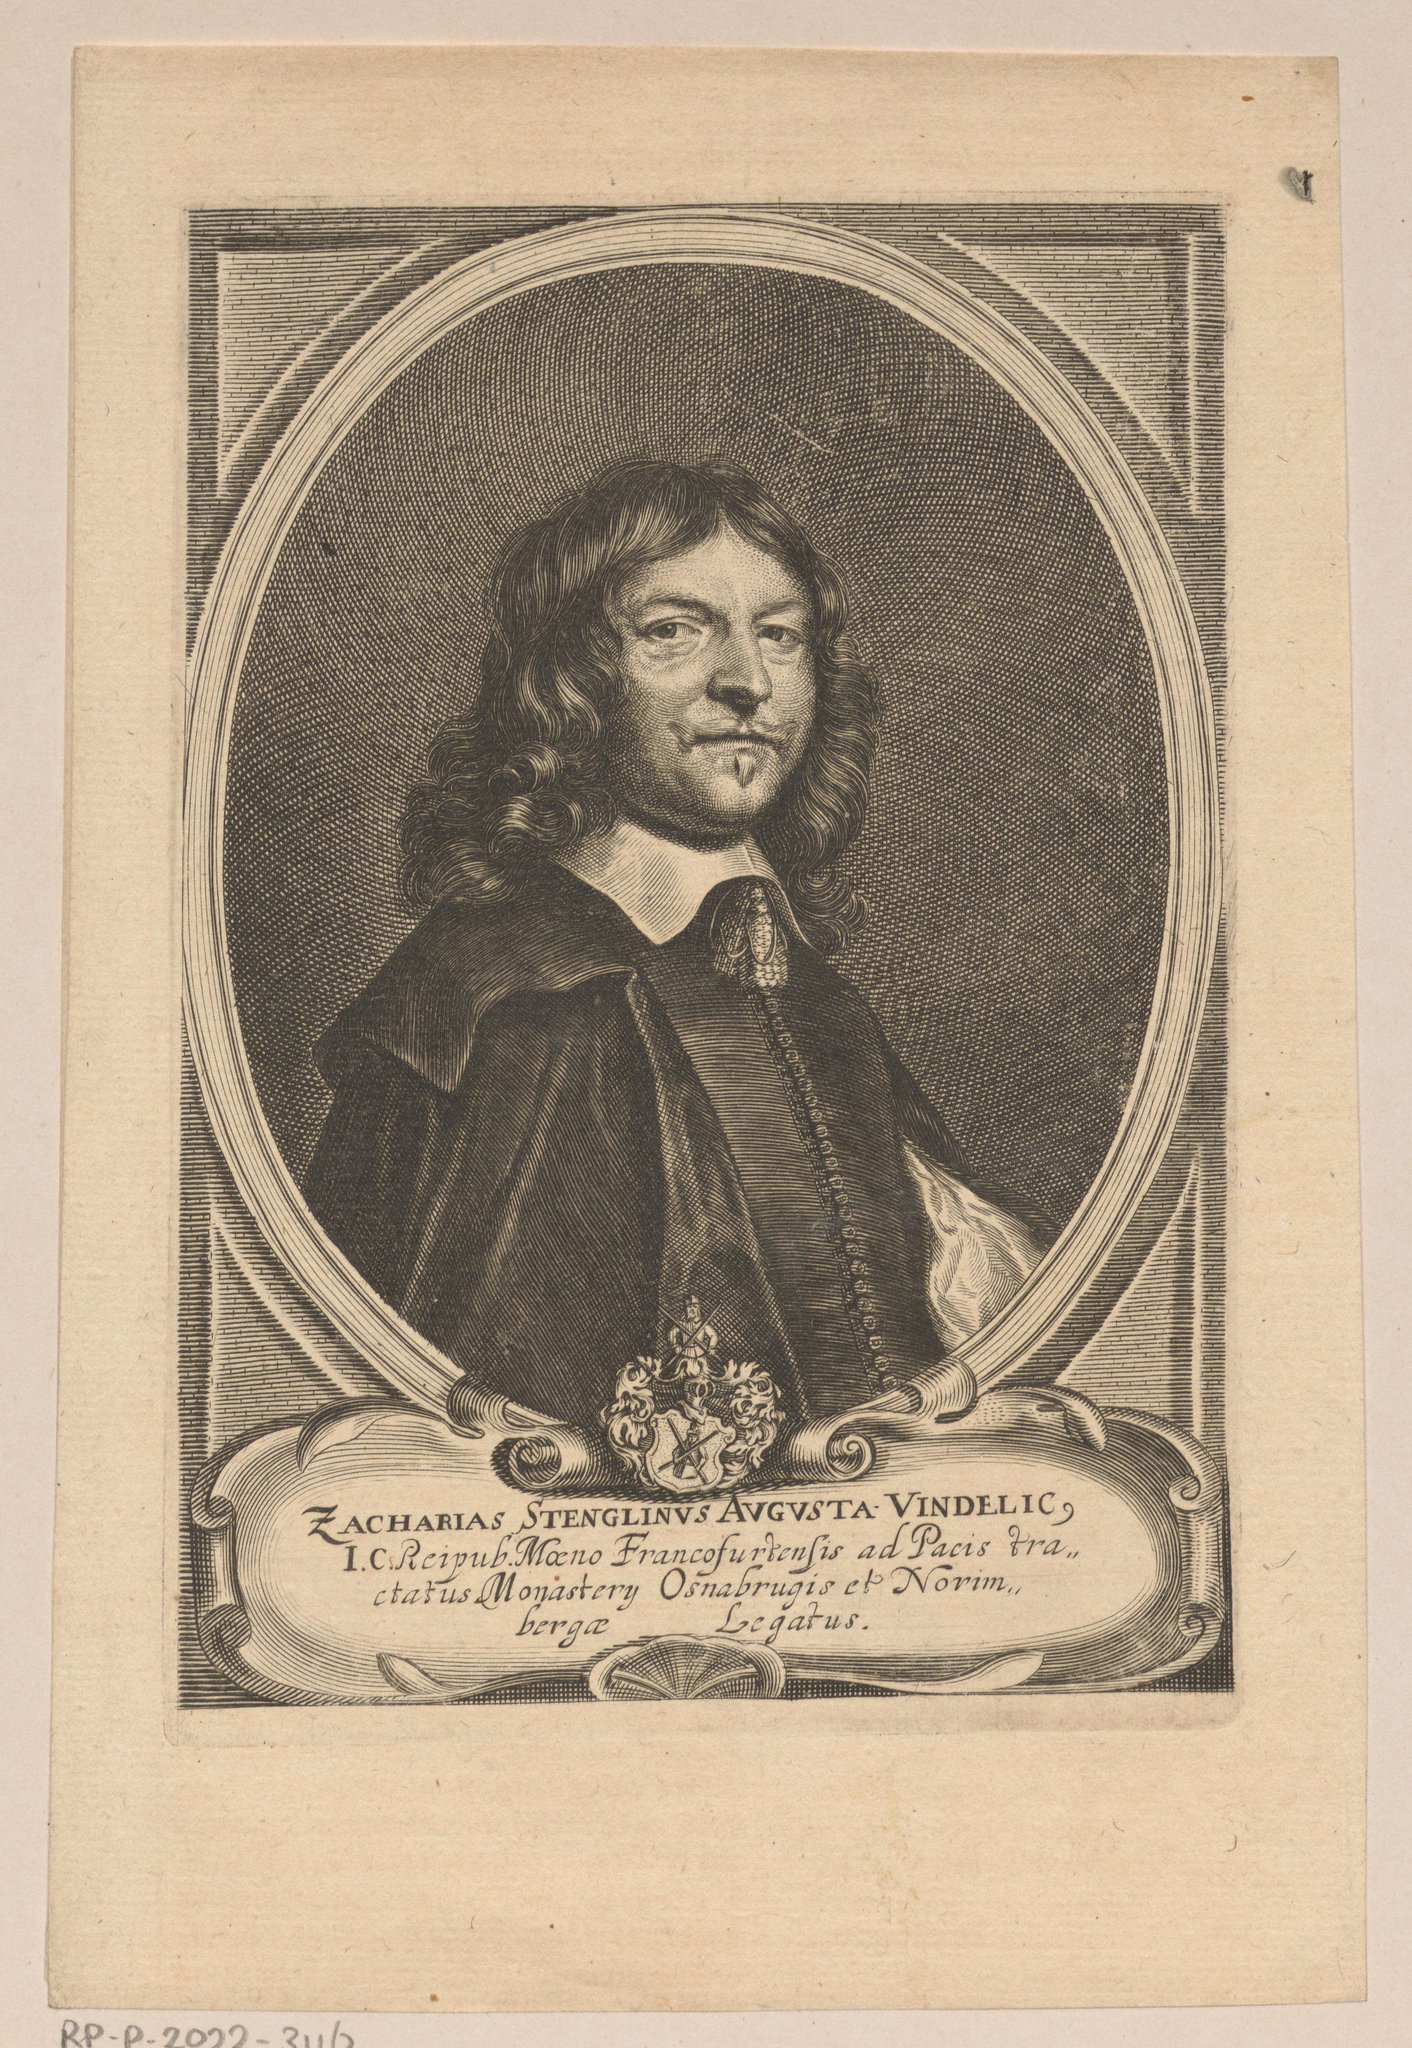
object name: print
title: Portret van Zacharias Stenglin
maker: matthäus merian (ii)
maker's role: painter, print maker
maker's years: 1621-1687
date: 1652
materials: paper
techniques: engraving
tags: augsburg, historical persons, lawyer, attorney at law, diplomacy, diplomat, armorial bearing, heraldry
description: Prent waarschijnlijk uit: Theatrum Europaeum (...). 1e druk. Frankfurt: erven Matthaus Merian, 1652, dl. 6. Mogelijk ook gebruikt in een latere druk van dit werk.